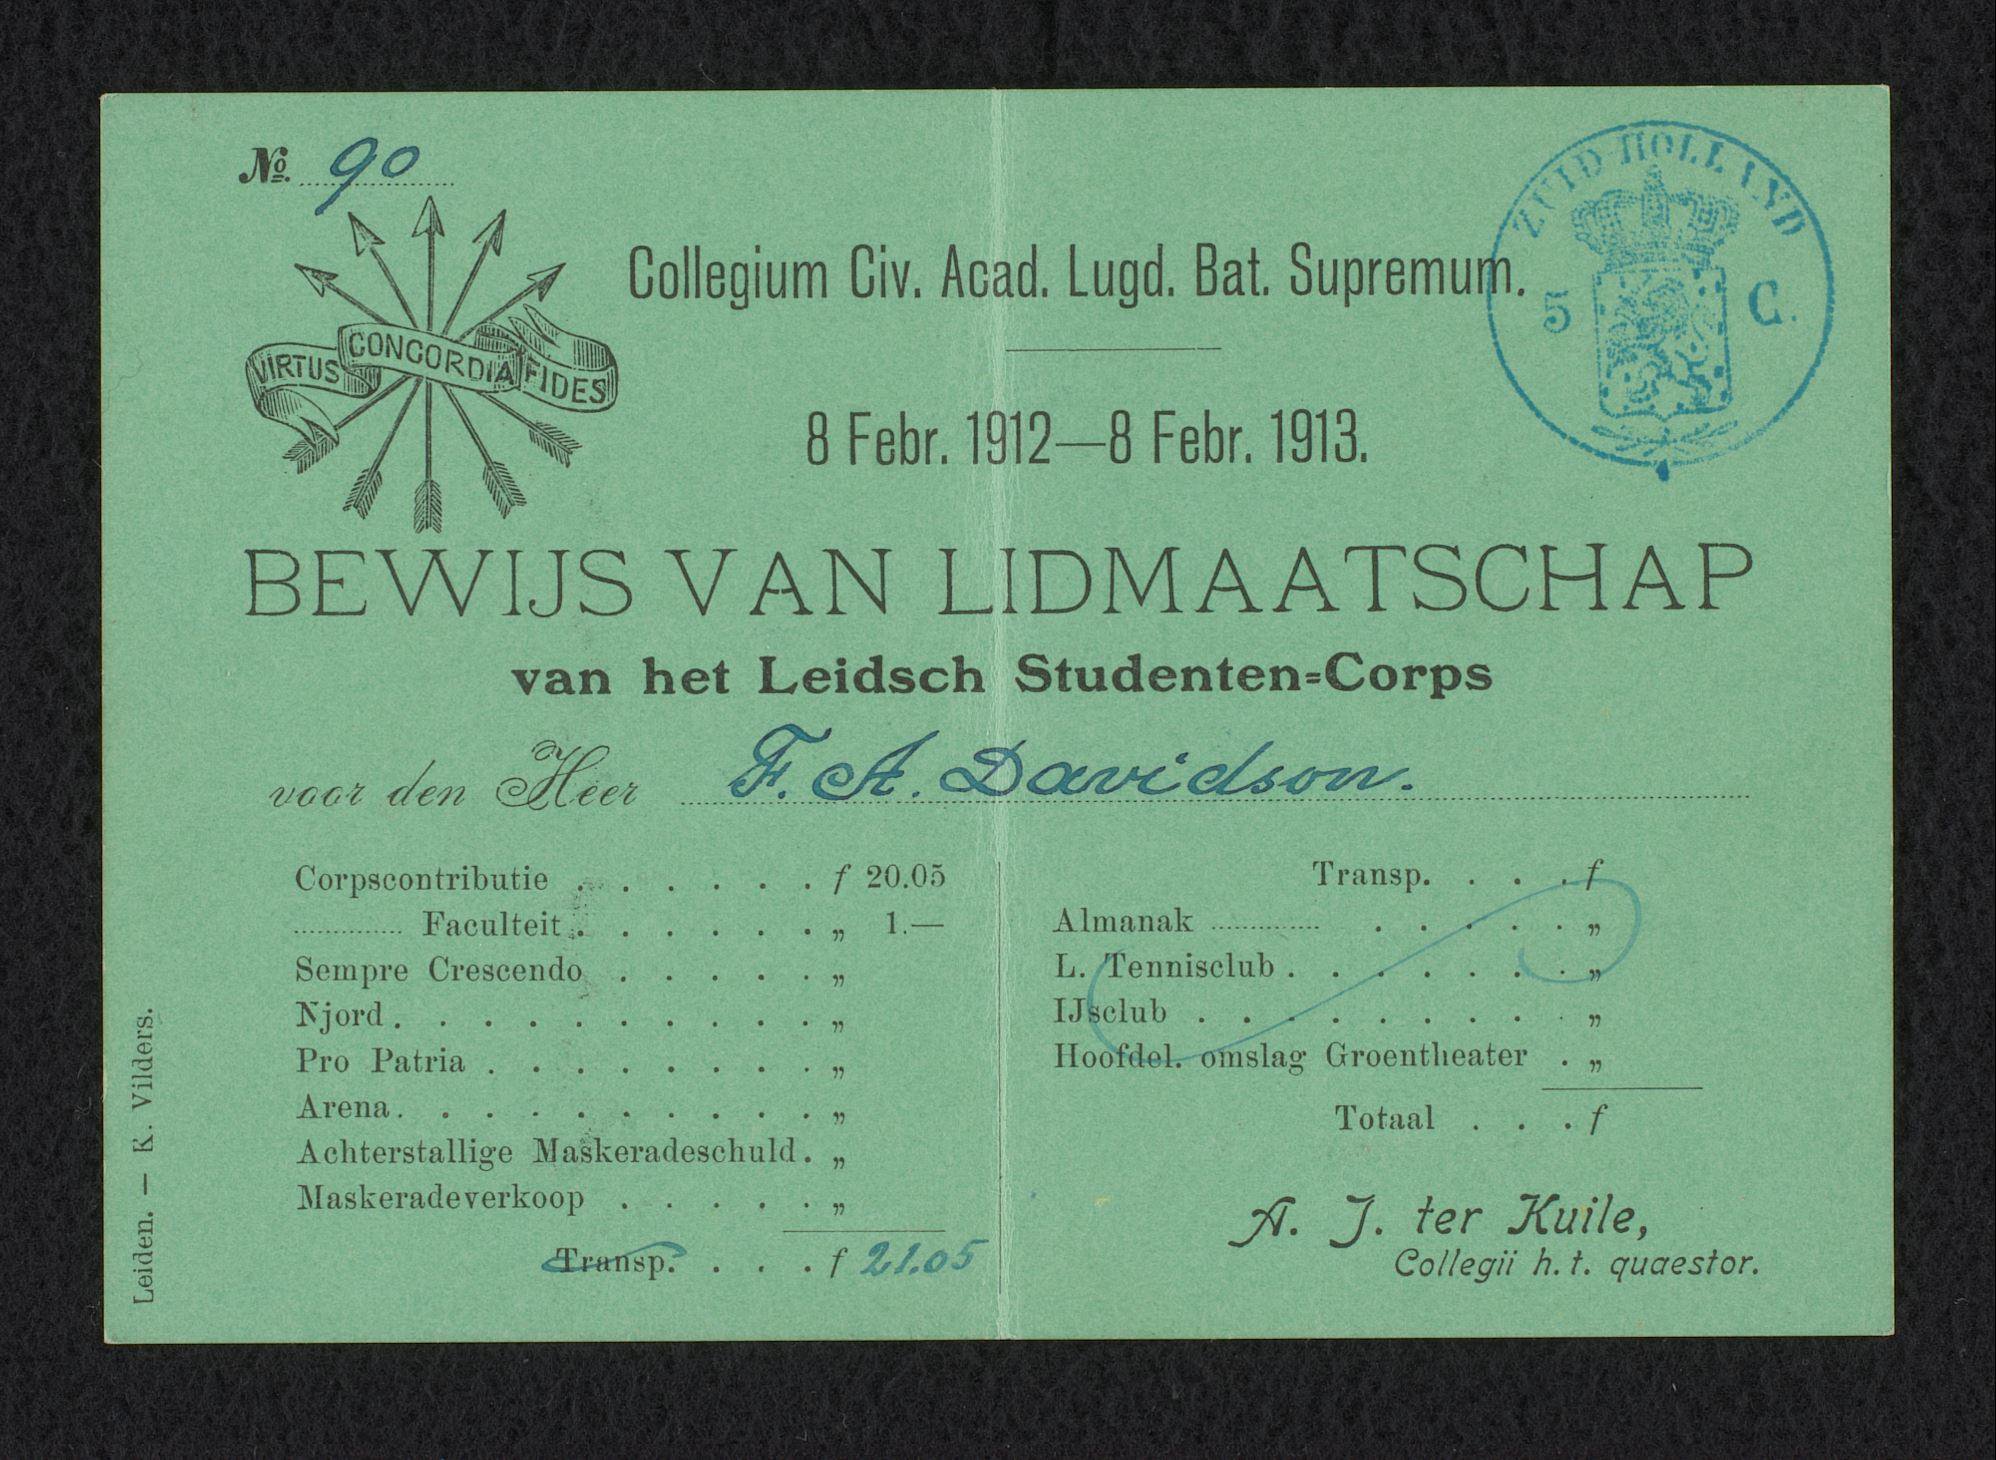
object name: membership certificate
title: Lidmaatschapsbewijs voor het Leidsch Studenten Corps voor 1912-1913 van F.A. Davidson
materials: paper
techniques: pen, printing block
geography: leiden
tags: fancy letters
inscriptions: stamp: ‘Zuid Holland 5 C.’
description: Rechtsboven een wapen van vijf gekruiste pijlen met op een lint de tekst: 'Virtus concordia fides'. Verder de ingevulde tekst van het lidmaatschap voor 8 februari 1912 tot 8 februari 1913.